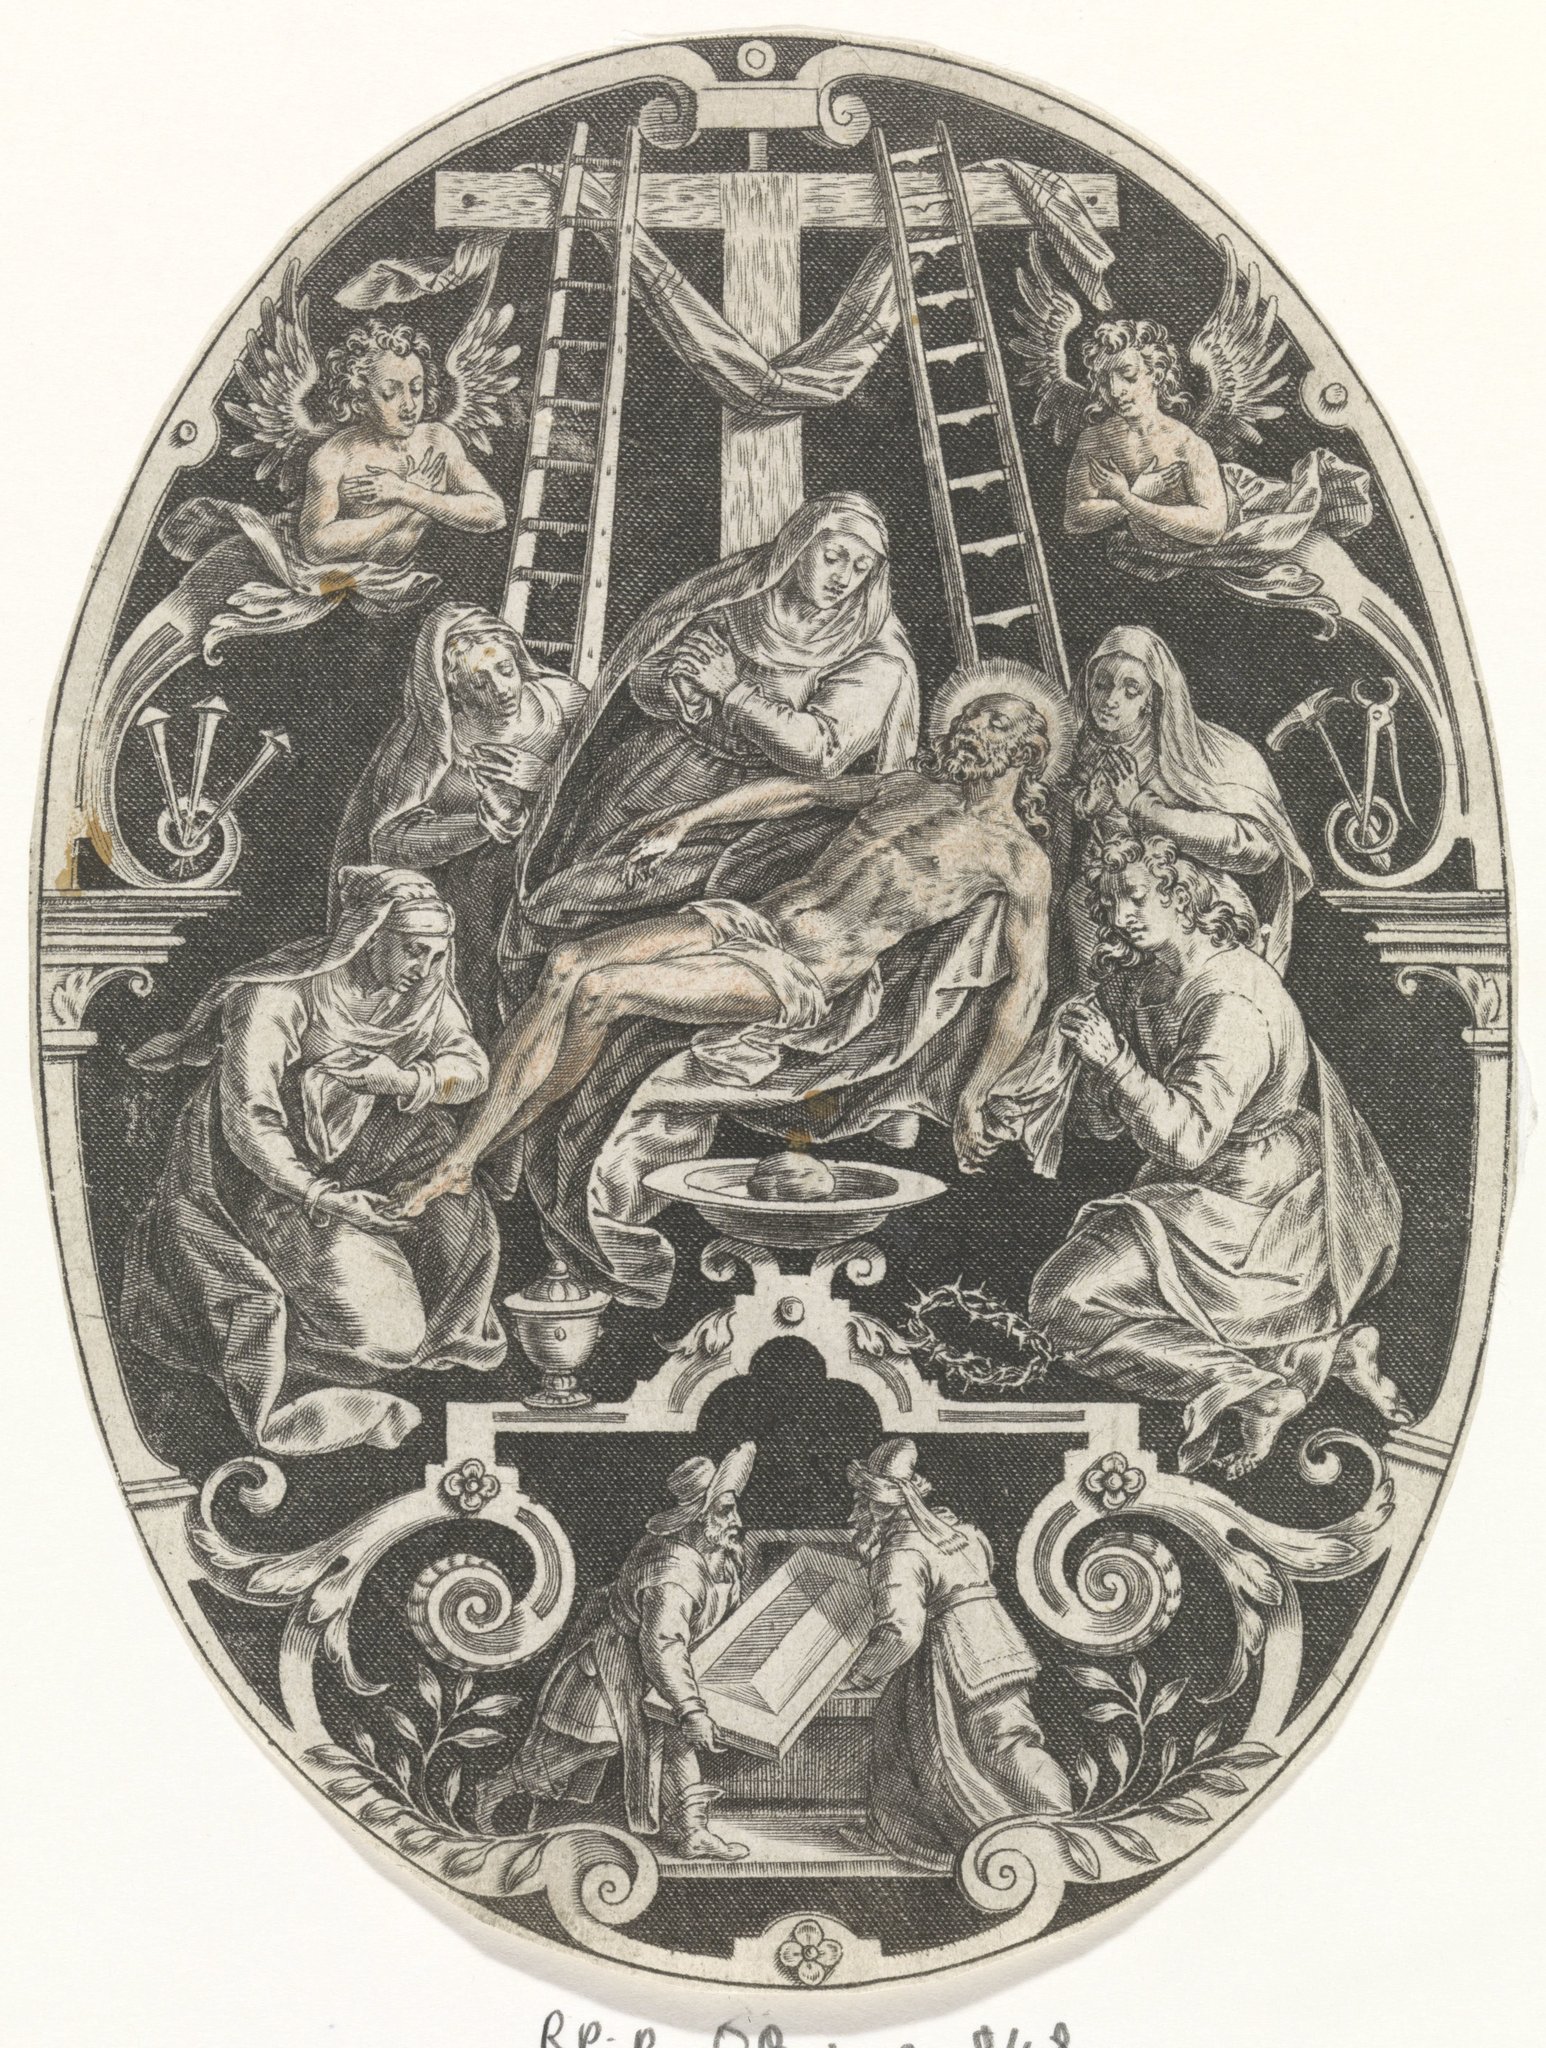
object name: print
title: Passie van Christus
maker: johann sadeler (i)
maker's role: print maker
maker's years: 1550-1600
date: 1560-1600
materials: paper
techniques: engraving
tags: christ's entombment (possibly by angels), ornaments ~ art, the mourning over the dead christ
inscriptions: collector's mark: Lugt 2228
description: Christus wordt door na de kruisafname door Maria en vier andere vrouwen beweend. In staand ovaal met ornament. Op de voorgrond sluiten twee mannen de graftombe met het lijk van Christus. De elfde prent van een dertiendelige serie ornamentprenten over de passie van Christus.